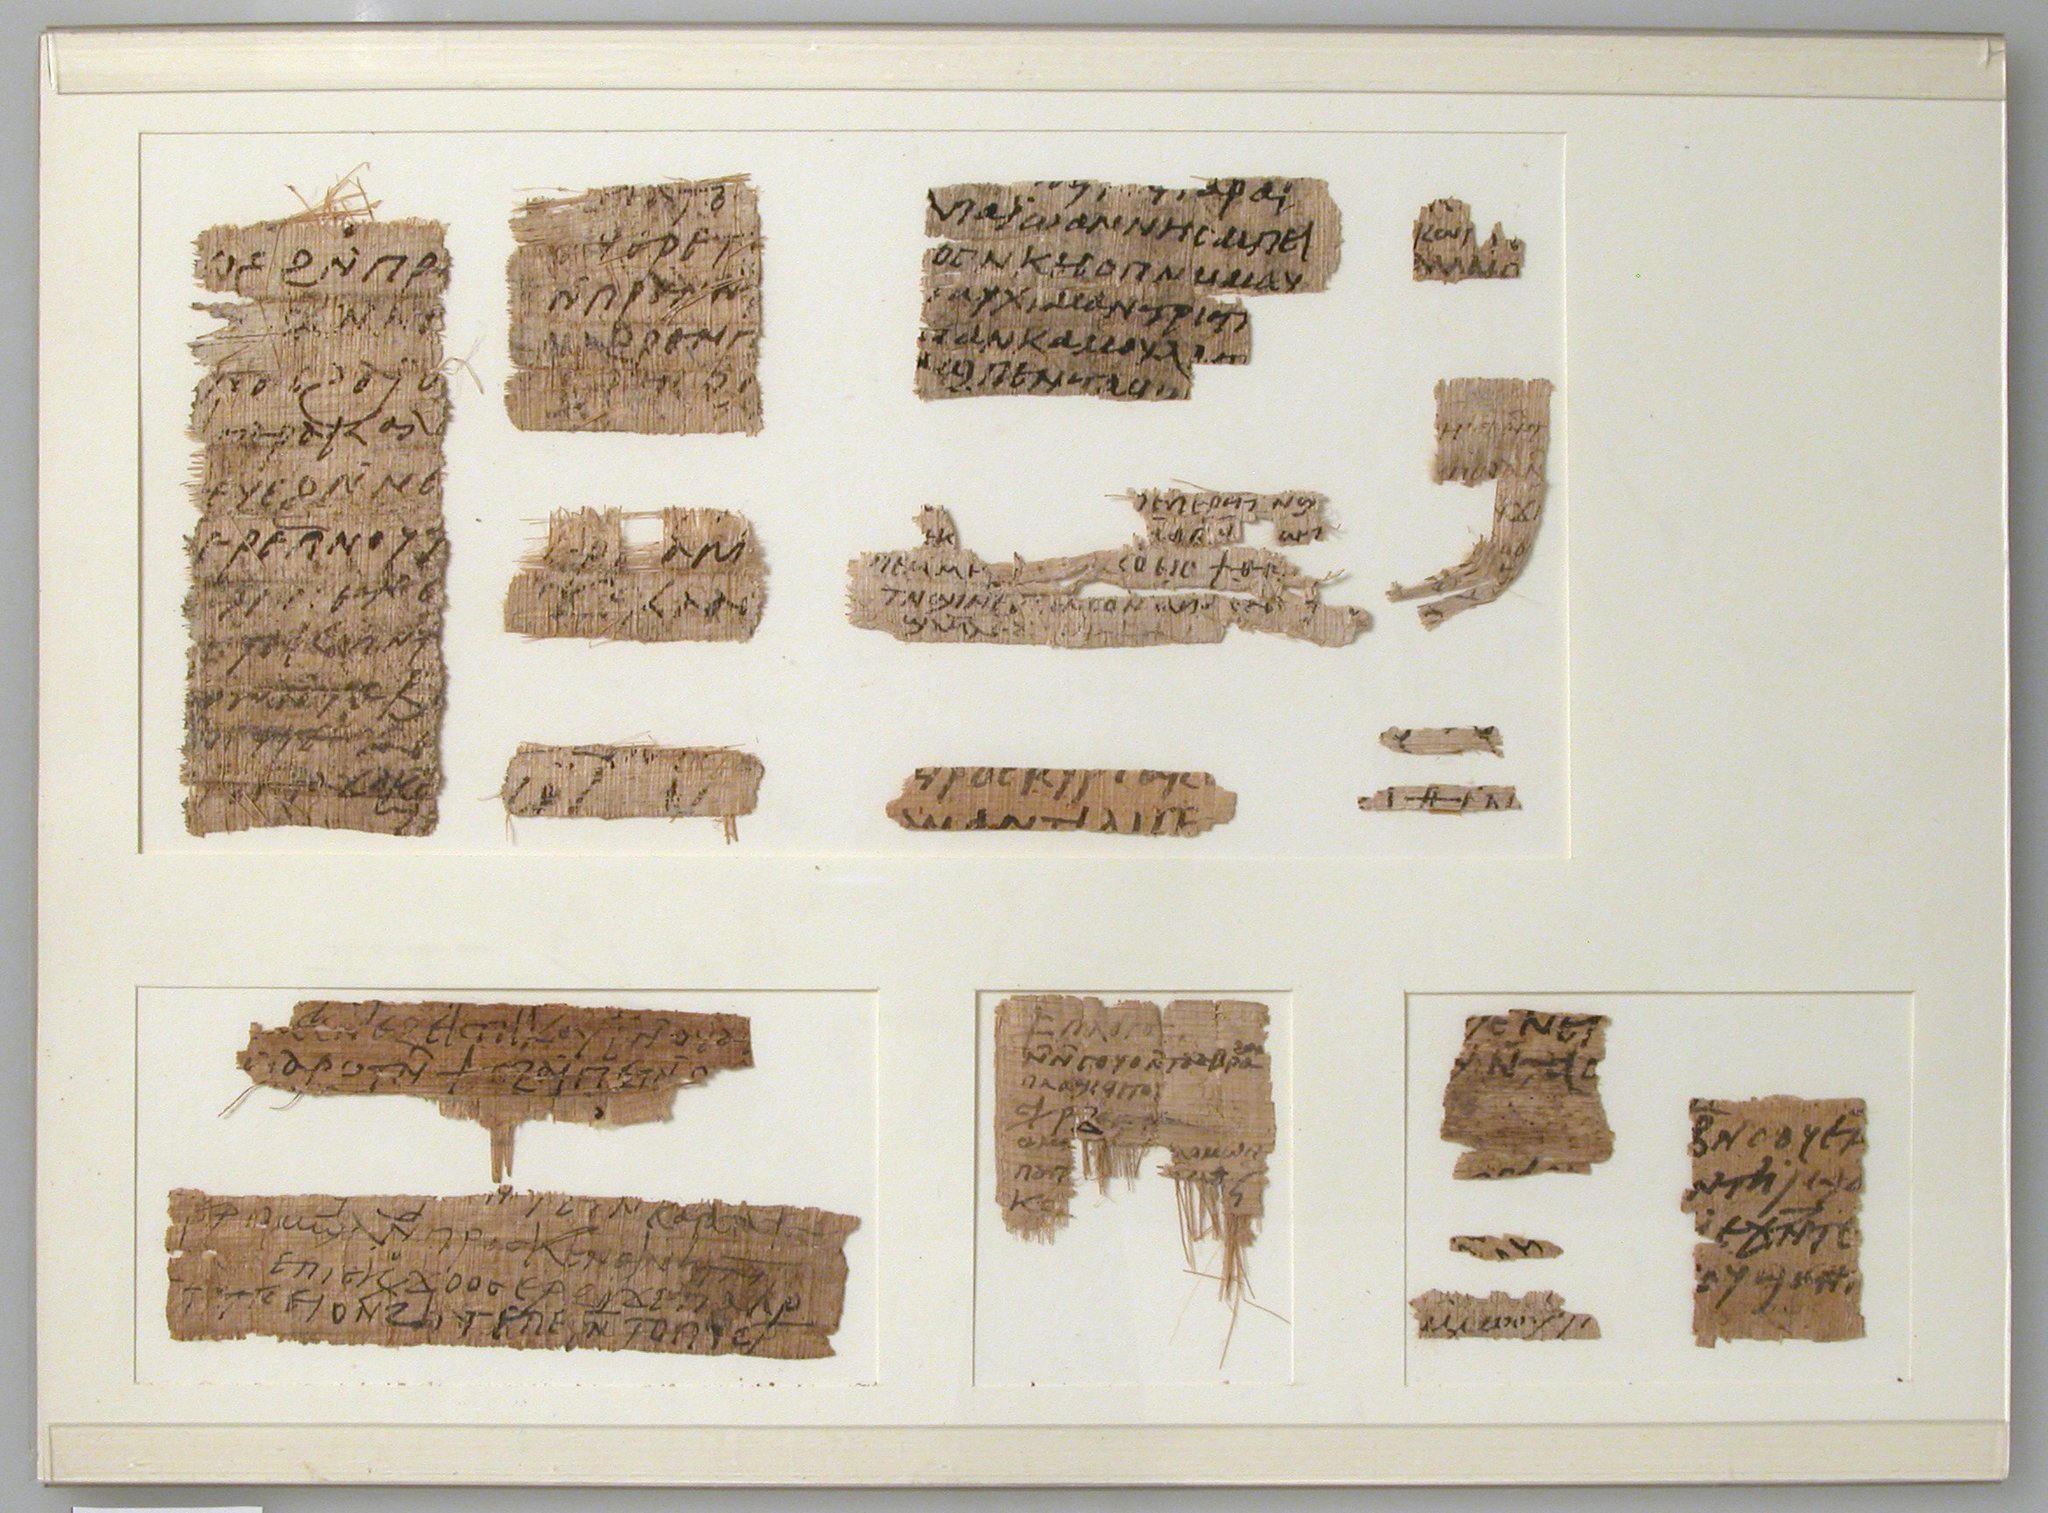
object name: fragment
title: Papyri Fragments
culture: coptic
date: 601-700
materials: ink, papyrus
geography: egypt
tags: documents